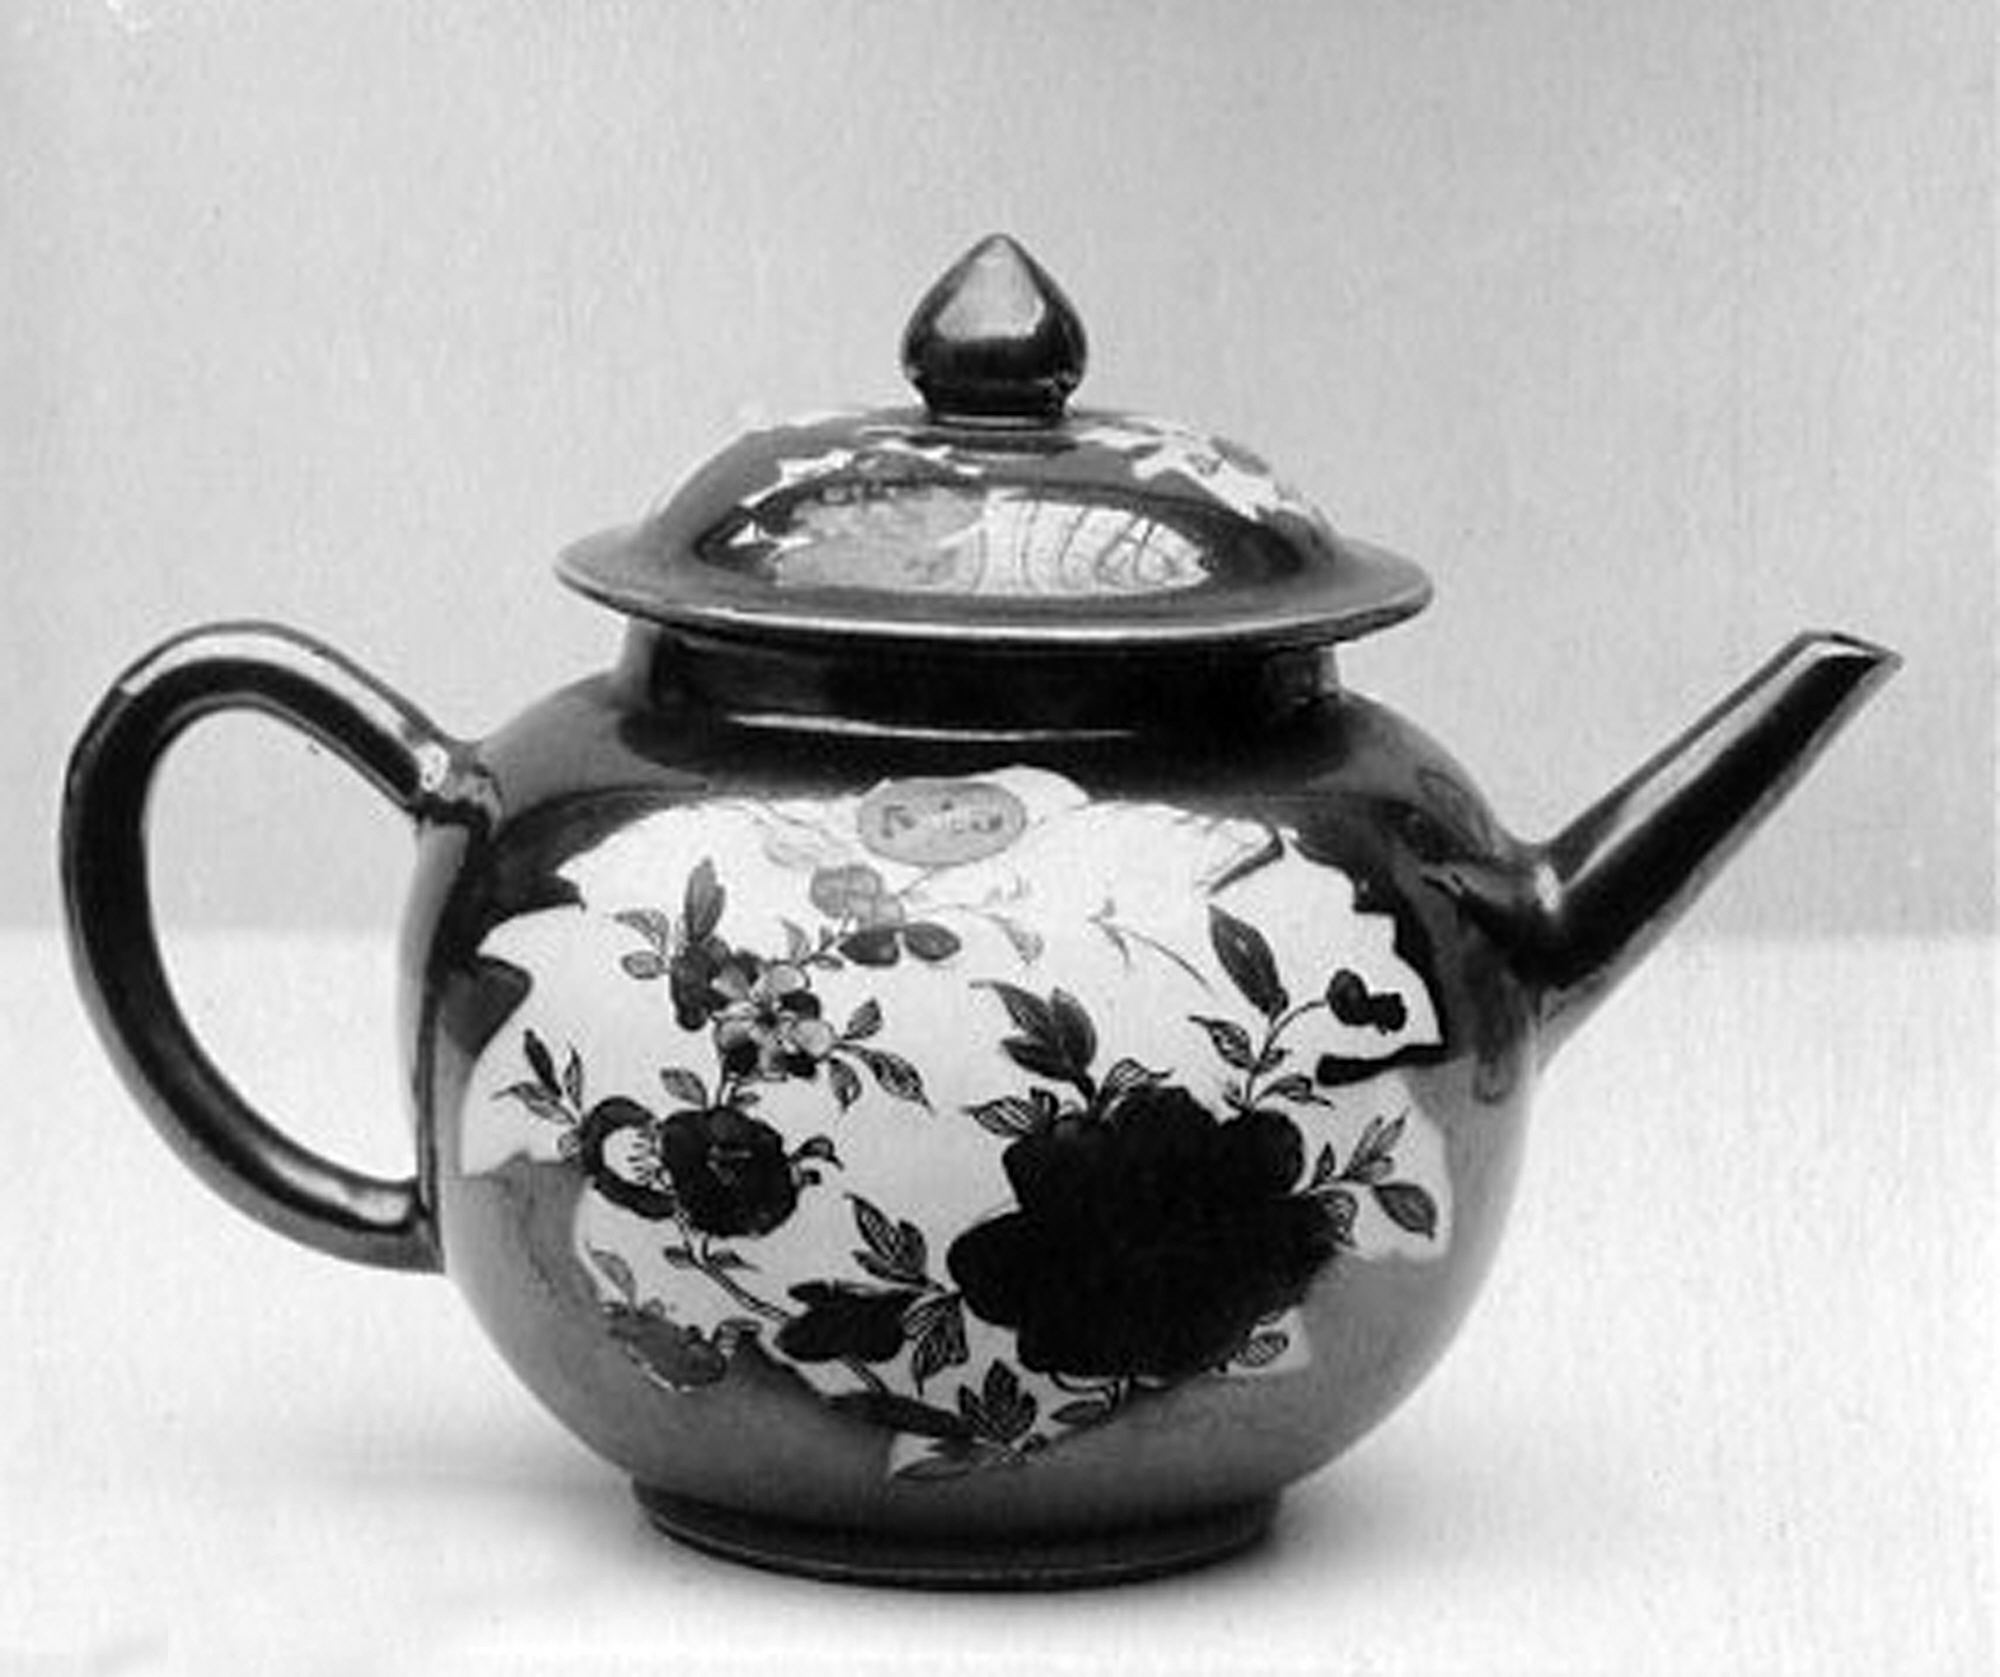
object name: teapot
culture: chinese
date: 1662-1722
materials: porcelain